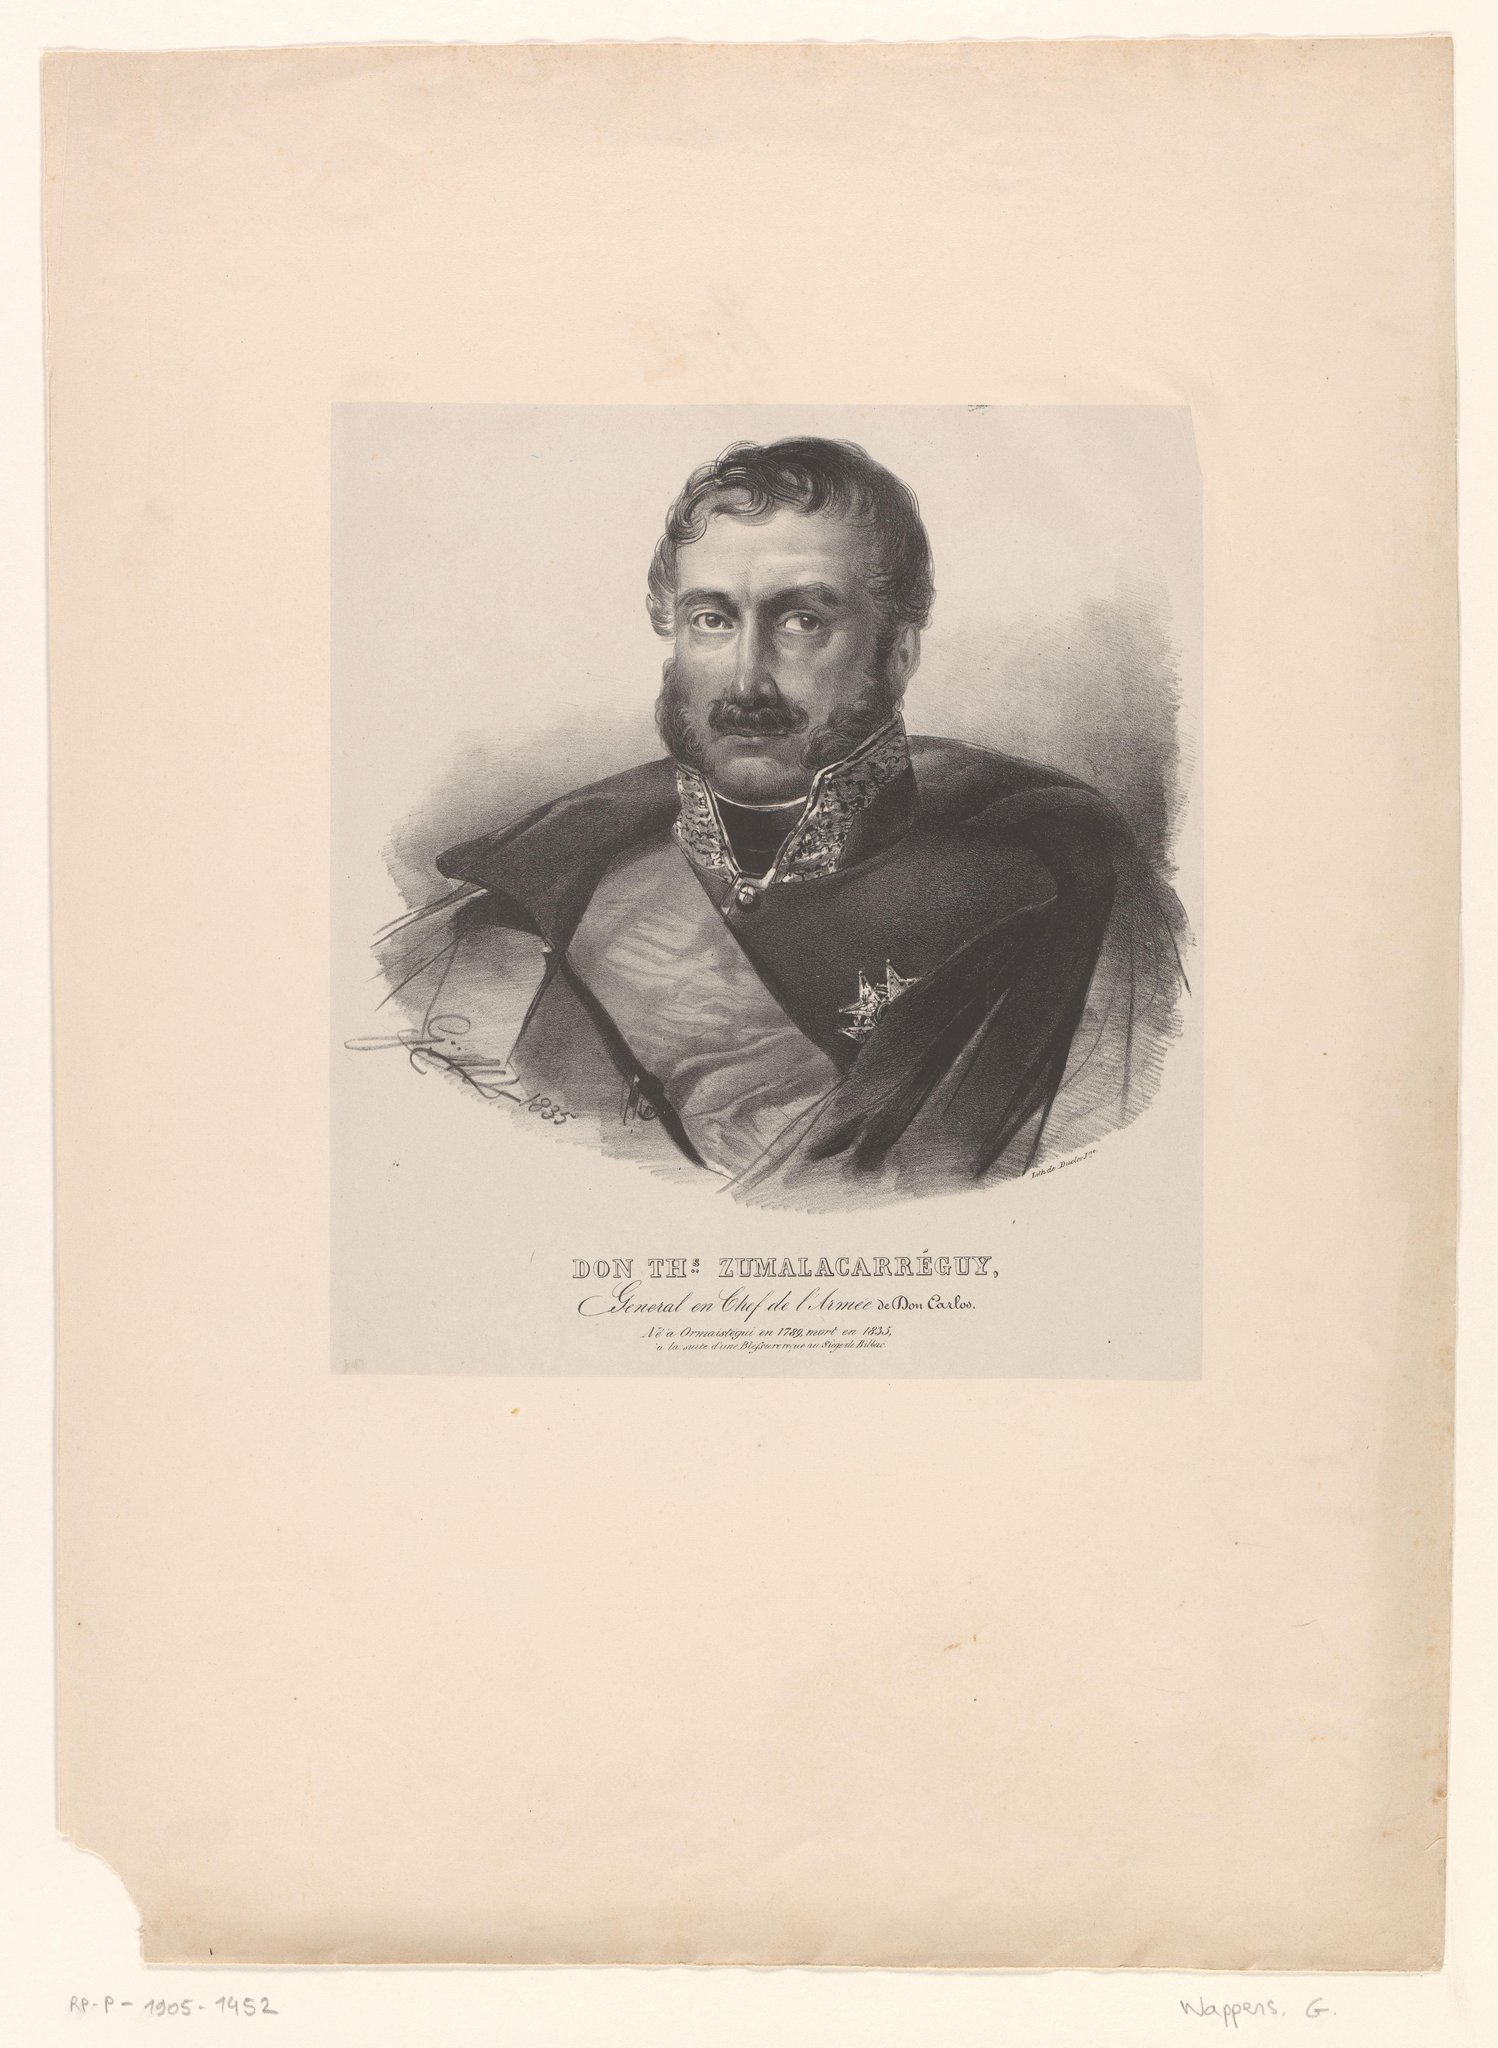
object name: print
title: Ths. Zumalacarréguy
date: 1835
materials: paper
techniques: lithograph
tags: ranks in the army, historical persons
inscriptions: collector's mark: Lugt 2228